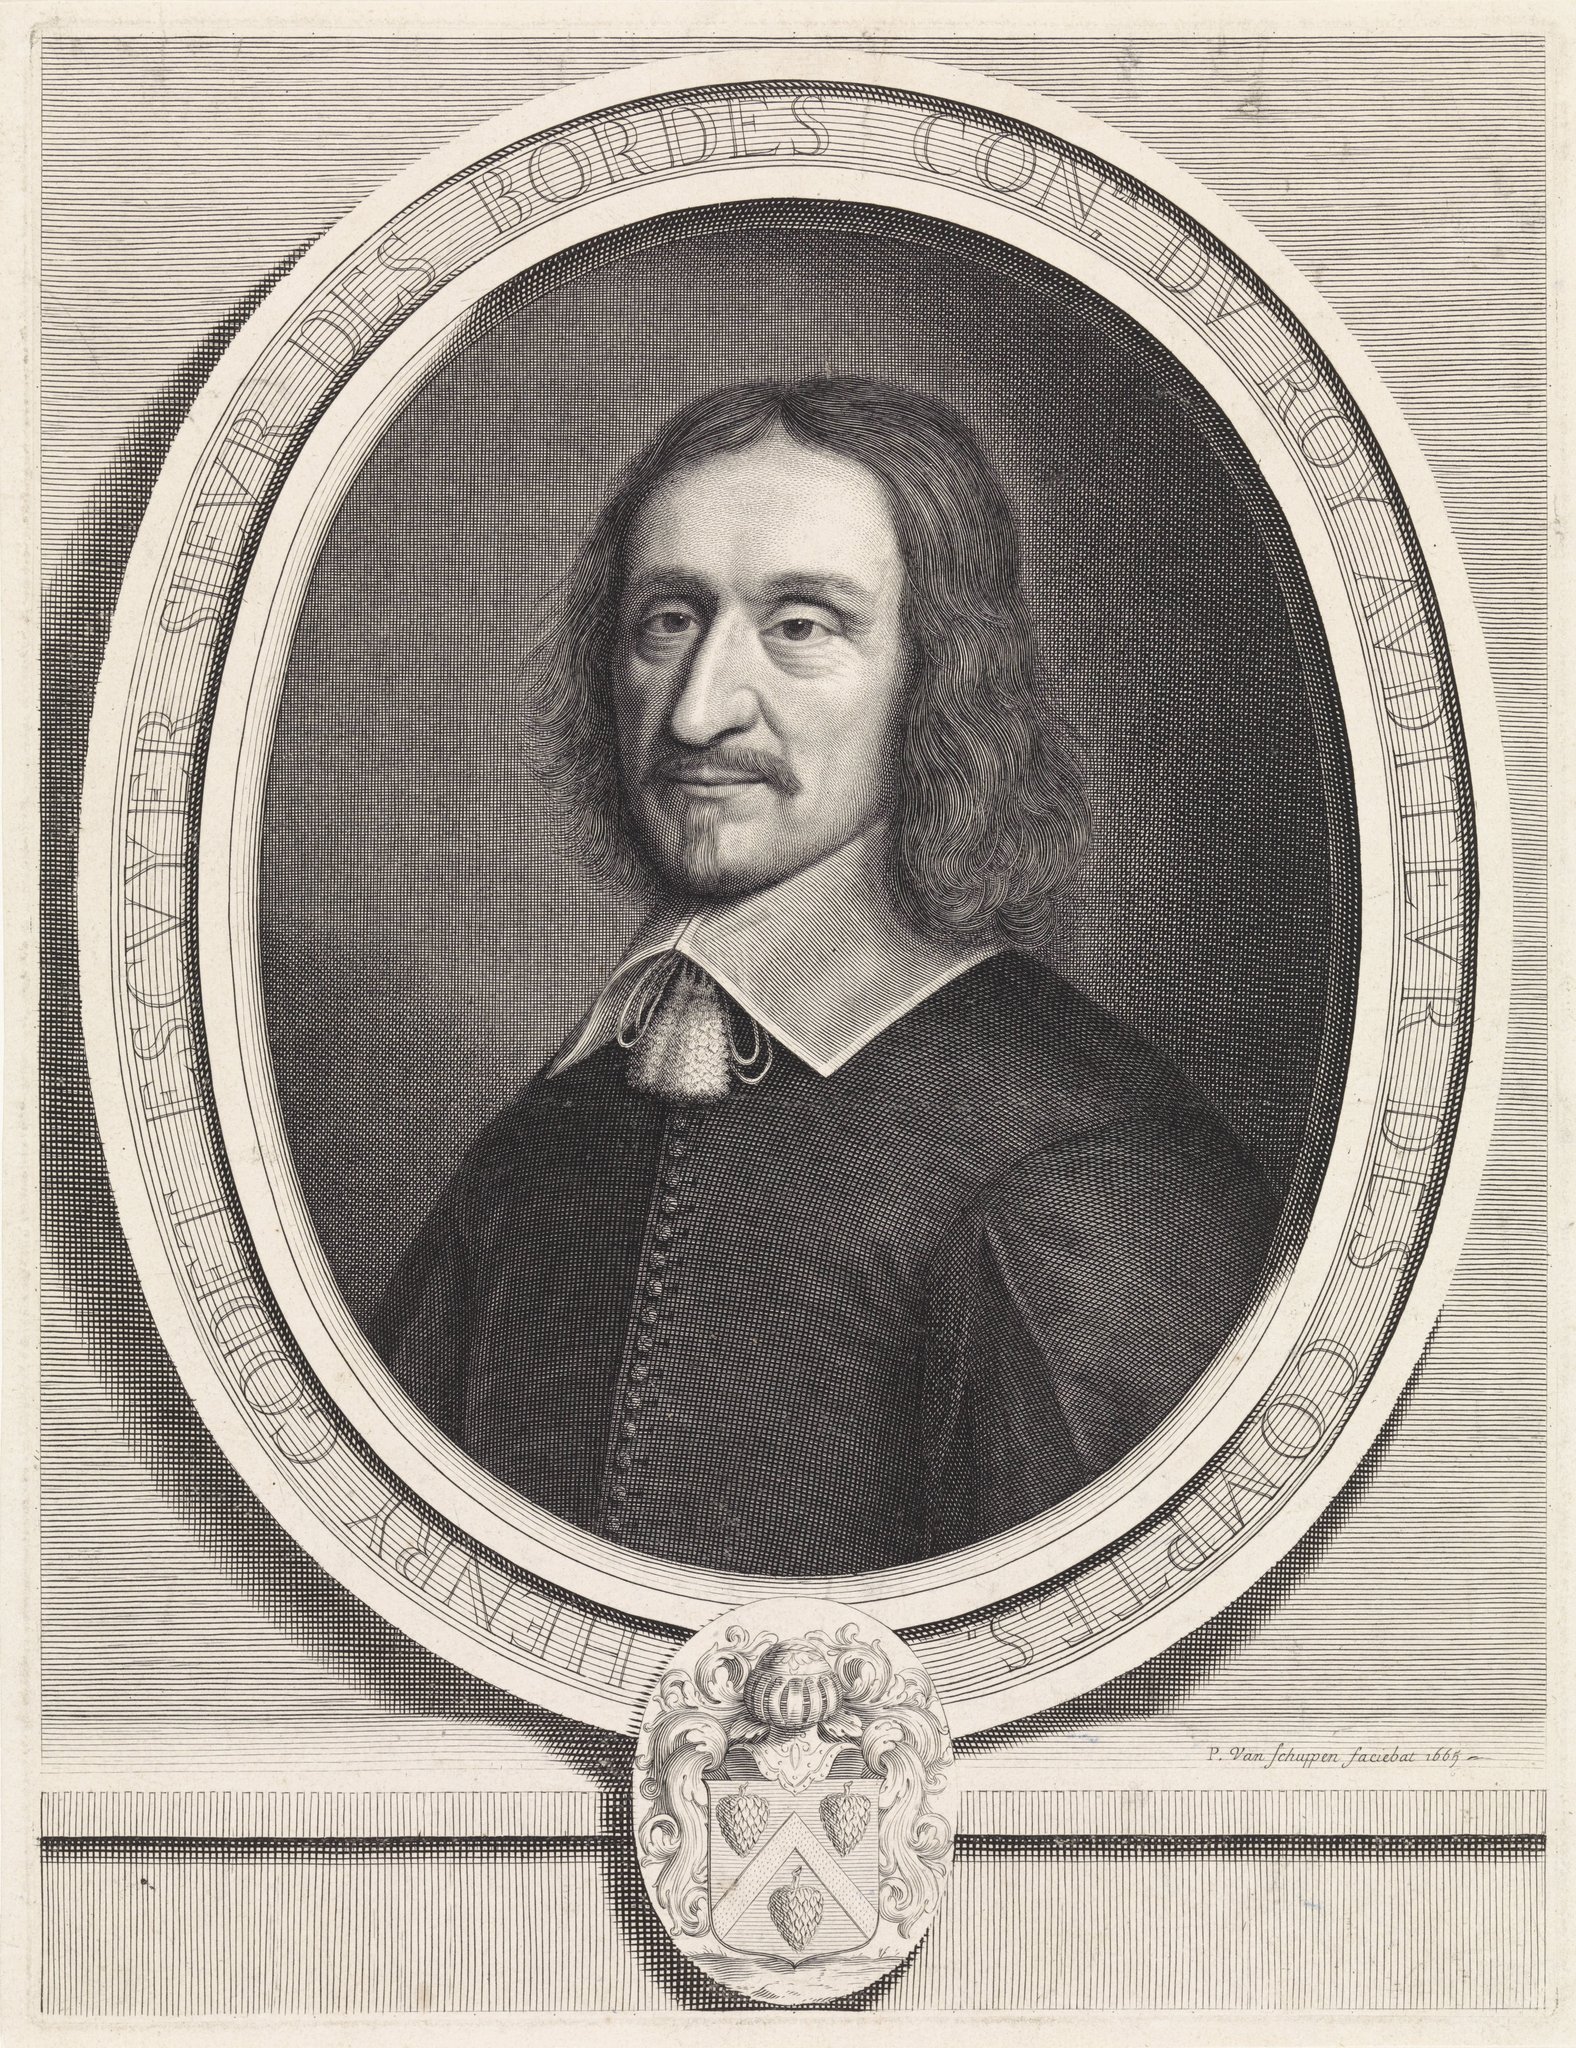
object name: print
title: Portret van Henry Godet des Bordes, auditeur des comptes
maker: pieter van schuppen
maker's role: print maker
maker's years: 1627-1702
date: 1606-1665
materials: paper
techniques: engraving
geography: paris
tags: henri godet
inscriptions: collector's mark: Lugt 2228